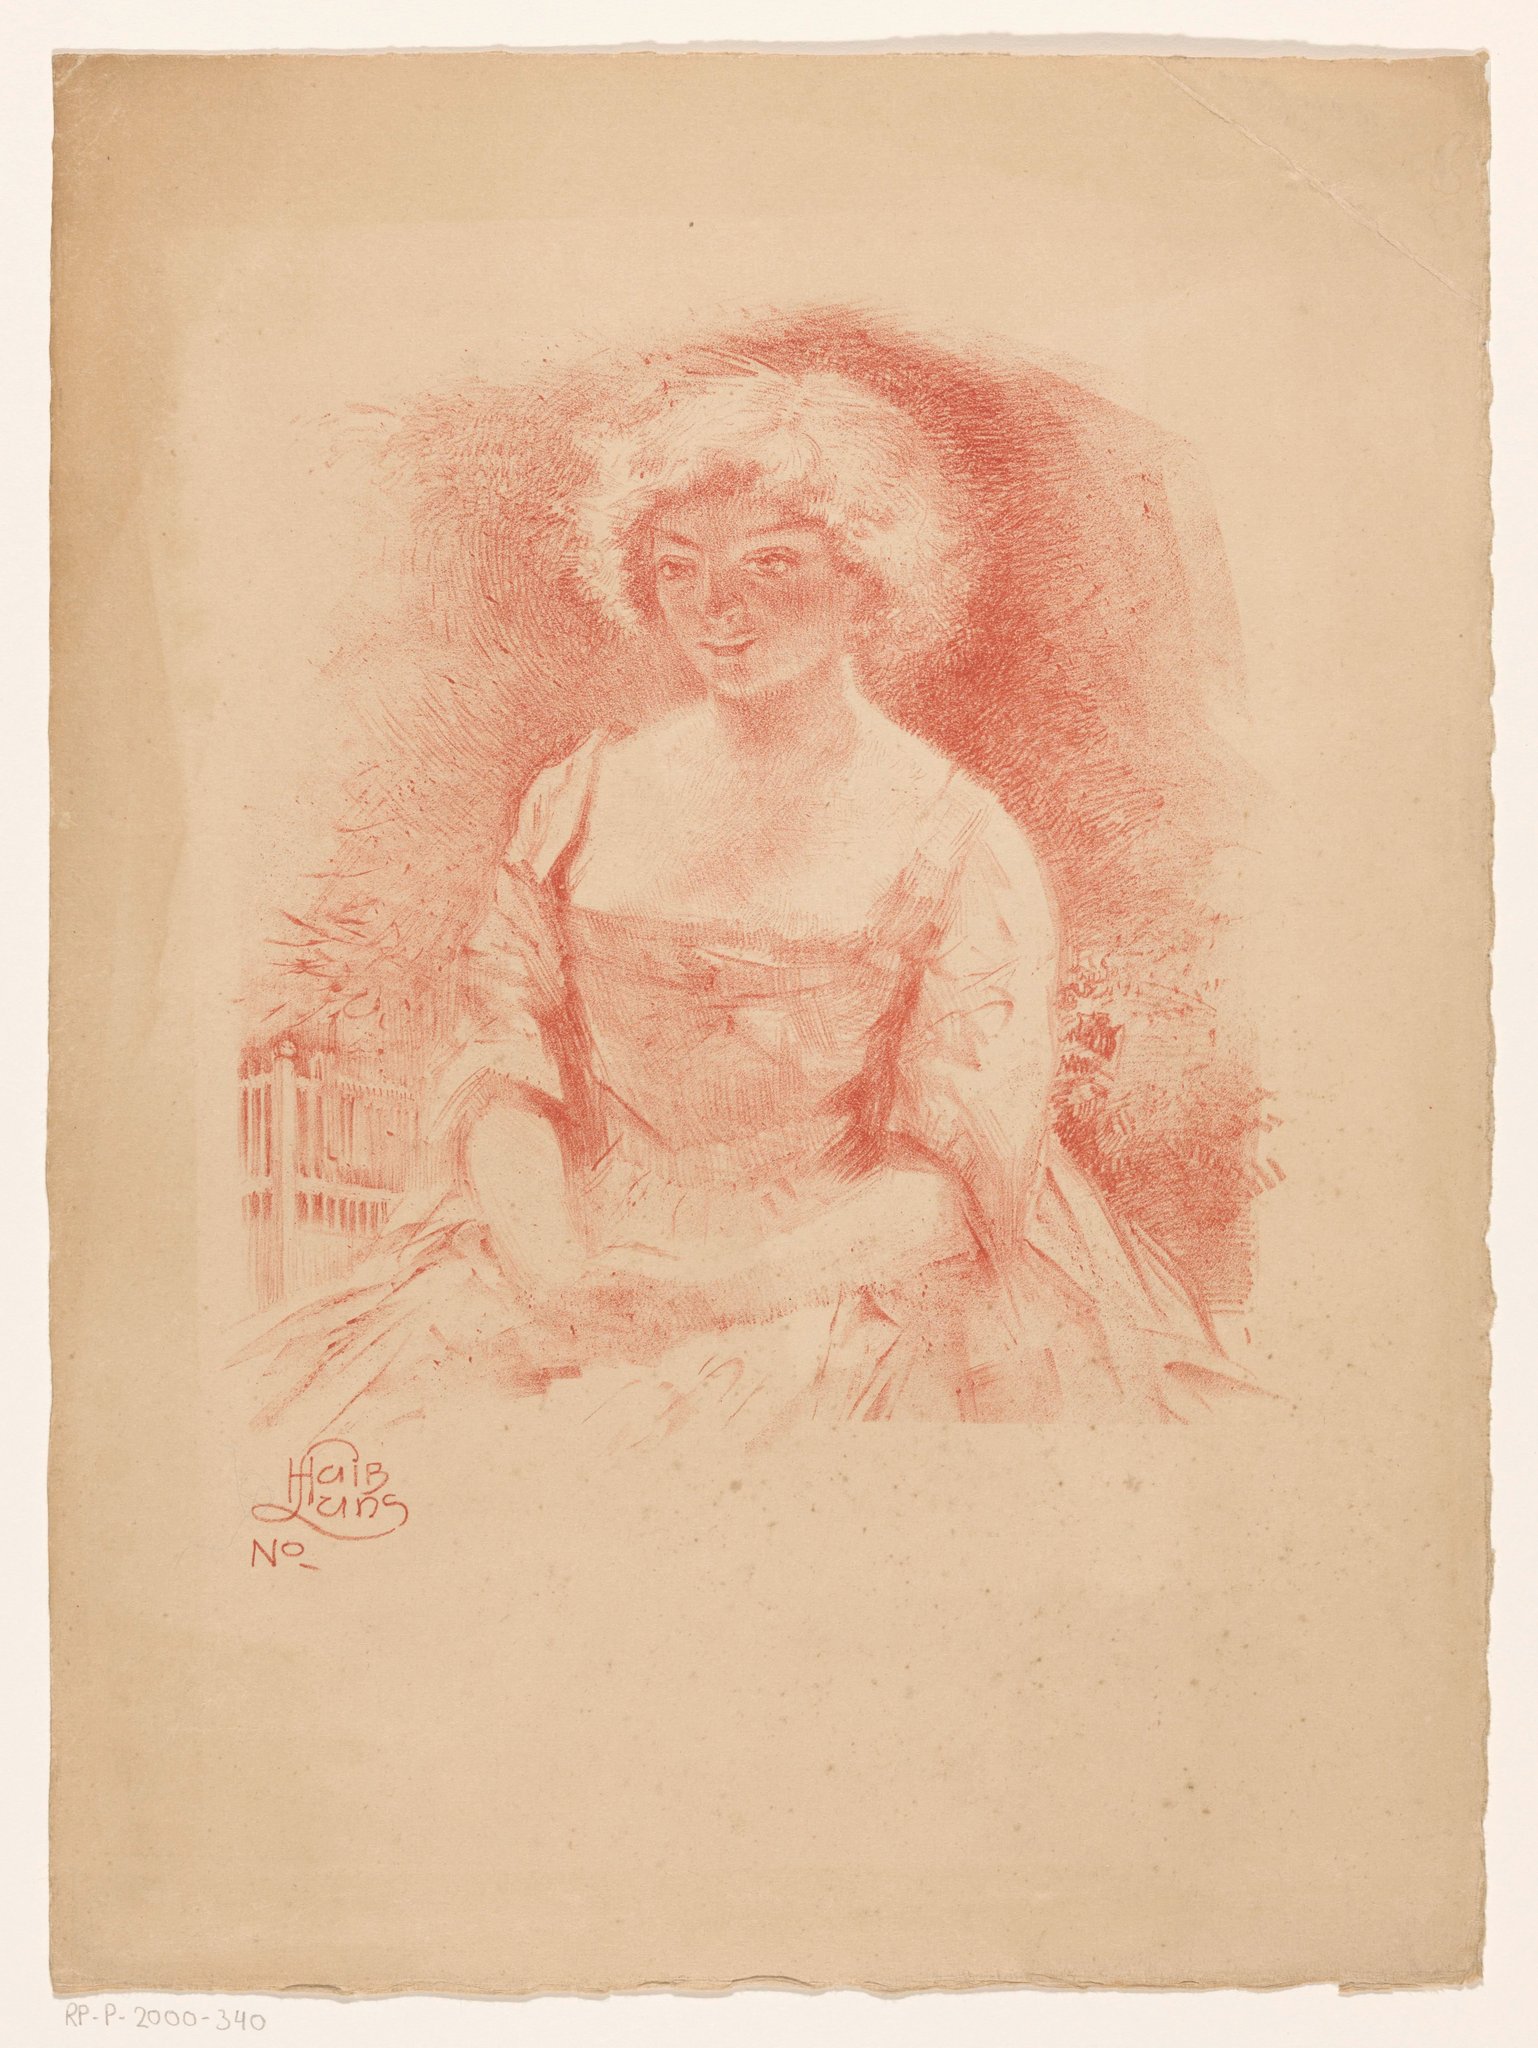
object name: print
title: Zittend meisje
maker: huib luns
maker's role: draughtsman, print maker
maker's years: 1881-1942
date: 1928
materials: paper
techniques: lithograph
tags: adolescent, young woman, maiden, hands folded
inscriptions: collector's mark: Lugt 2760, collector's mark: Lugt 2228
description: Een zittend meisje in een jurk met wijde hals met haar handen gevouwen in haar schoot.